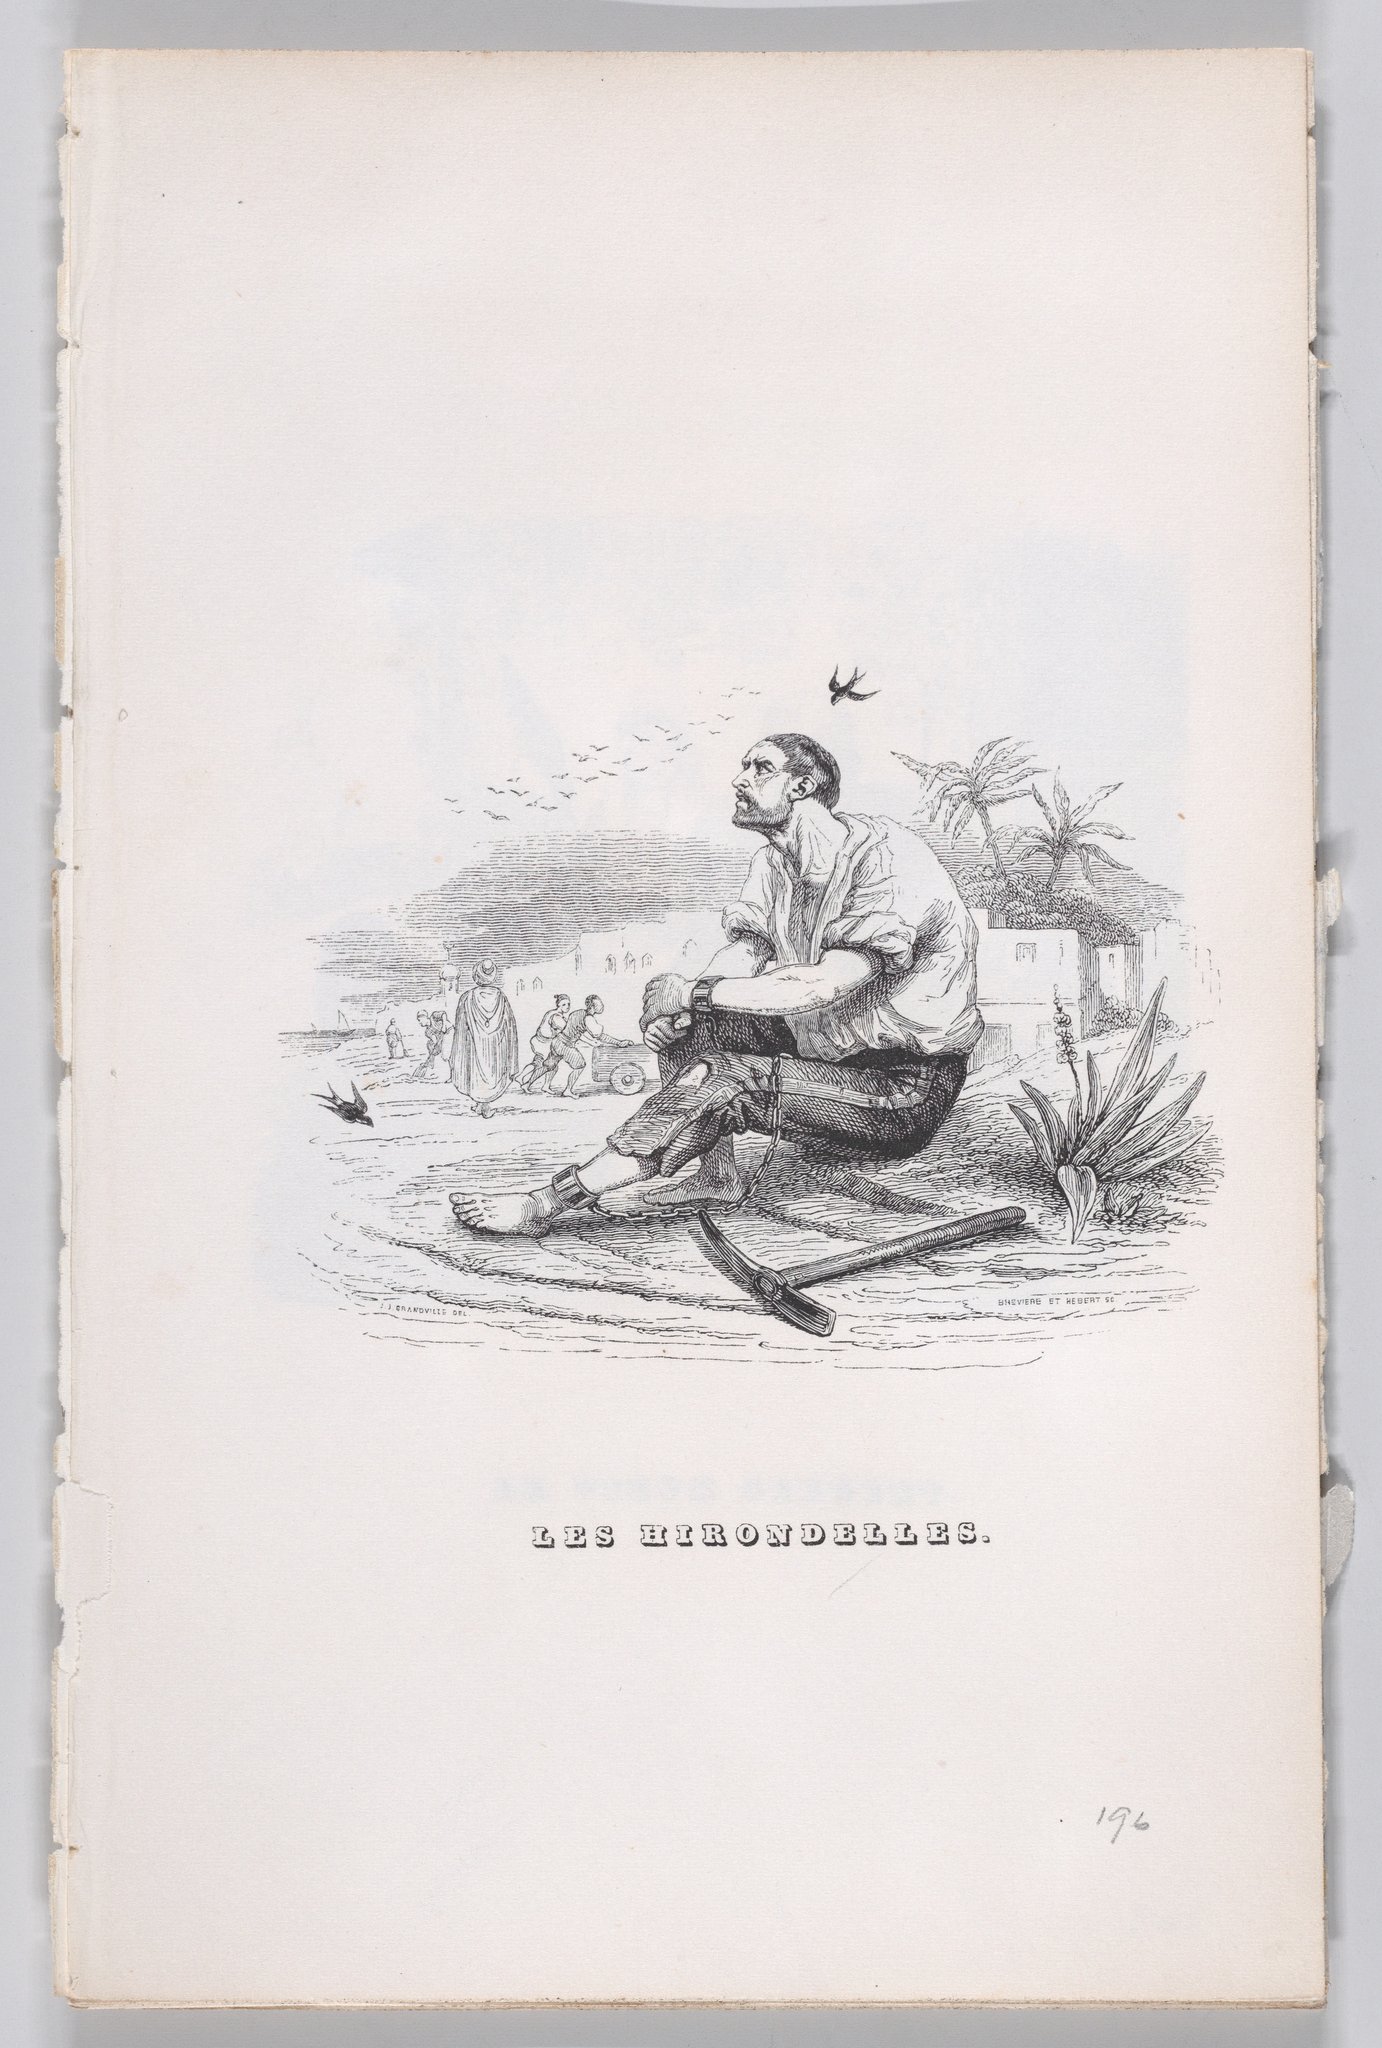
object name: print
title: The Swallows, from "The Complete Works of Béranger"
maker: j. j. grandville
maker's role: illustrator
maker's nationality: french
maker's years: 1803-1847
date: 1836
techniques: engraving